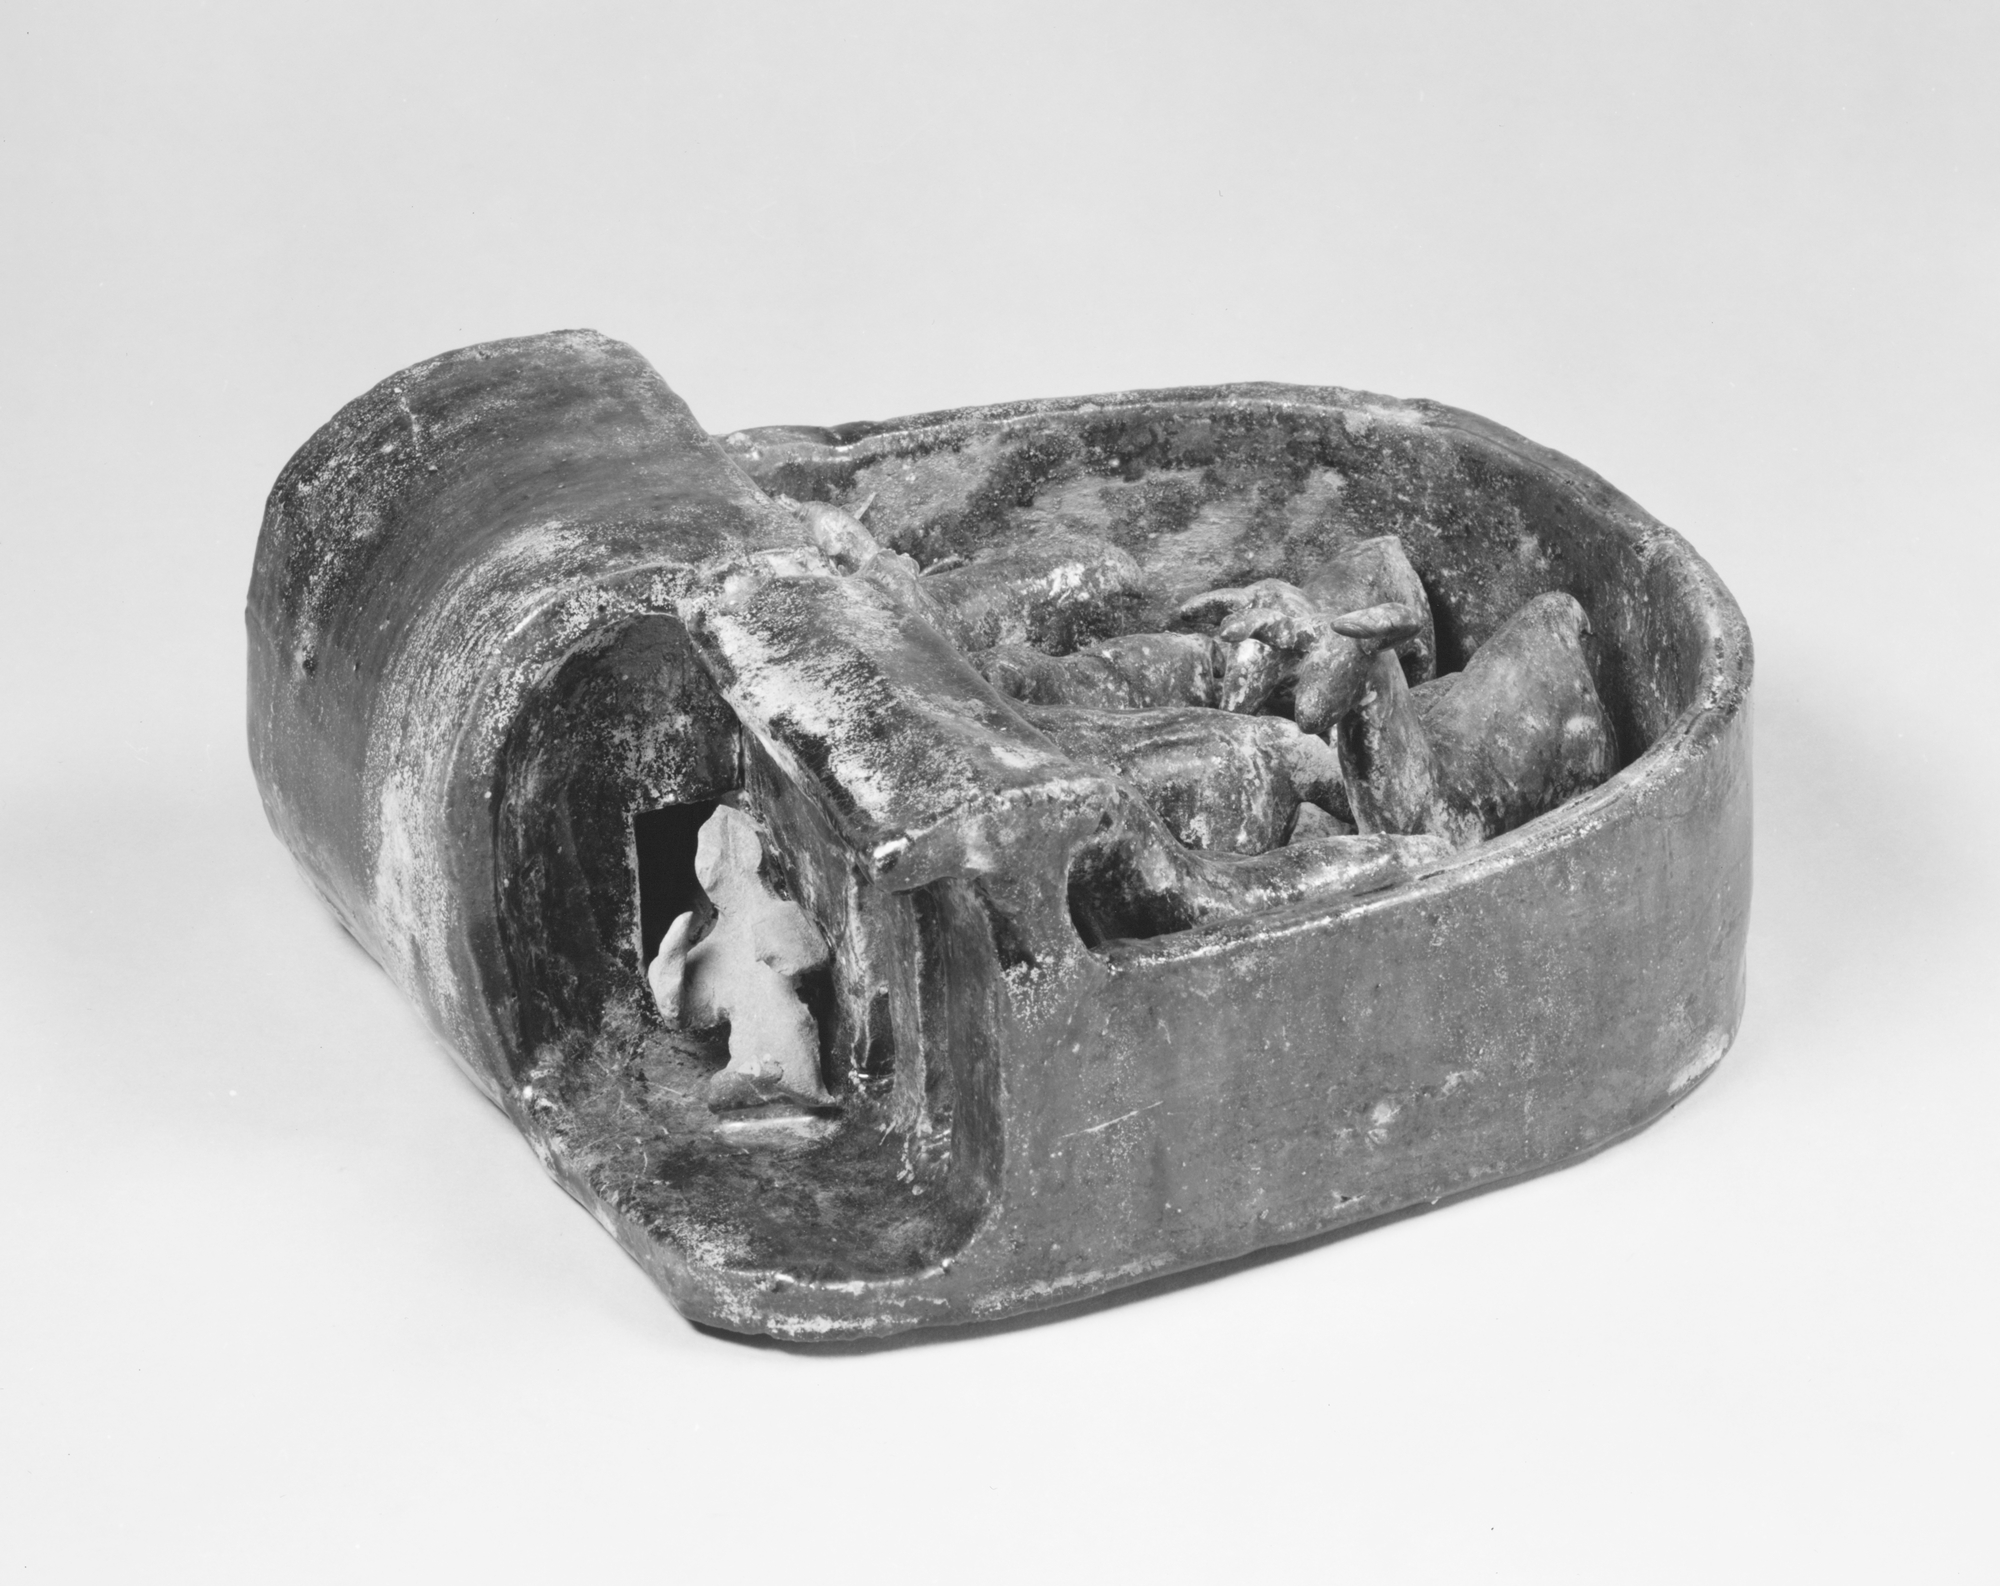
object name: architectural model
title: Goat Pen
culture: chinese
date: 1-233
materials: earthenware, glaze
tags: farms,goats